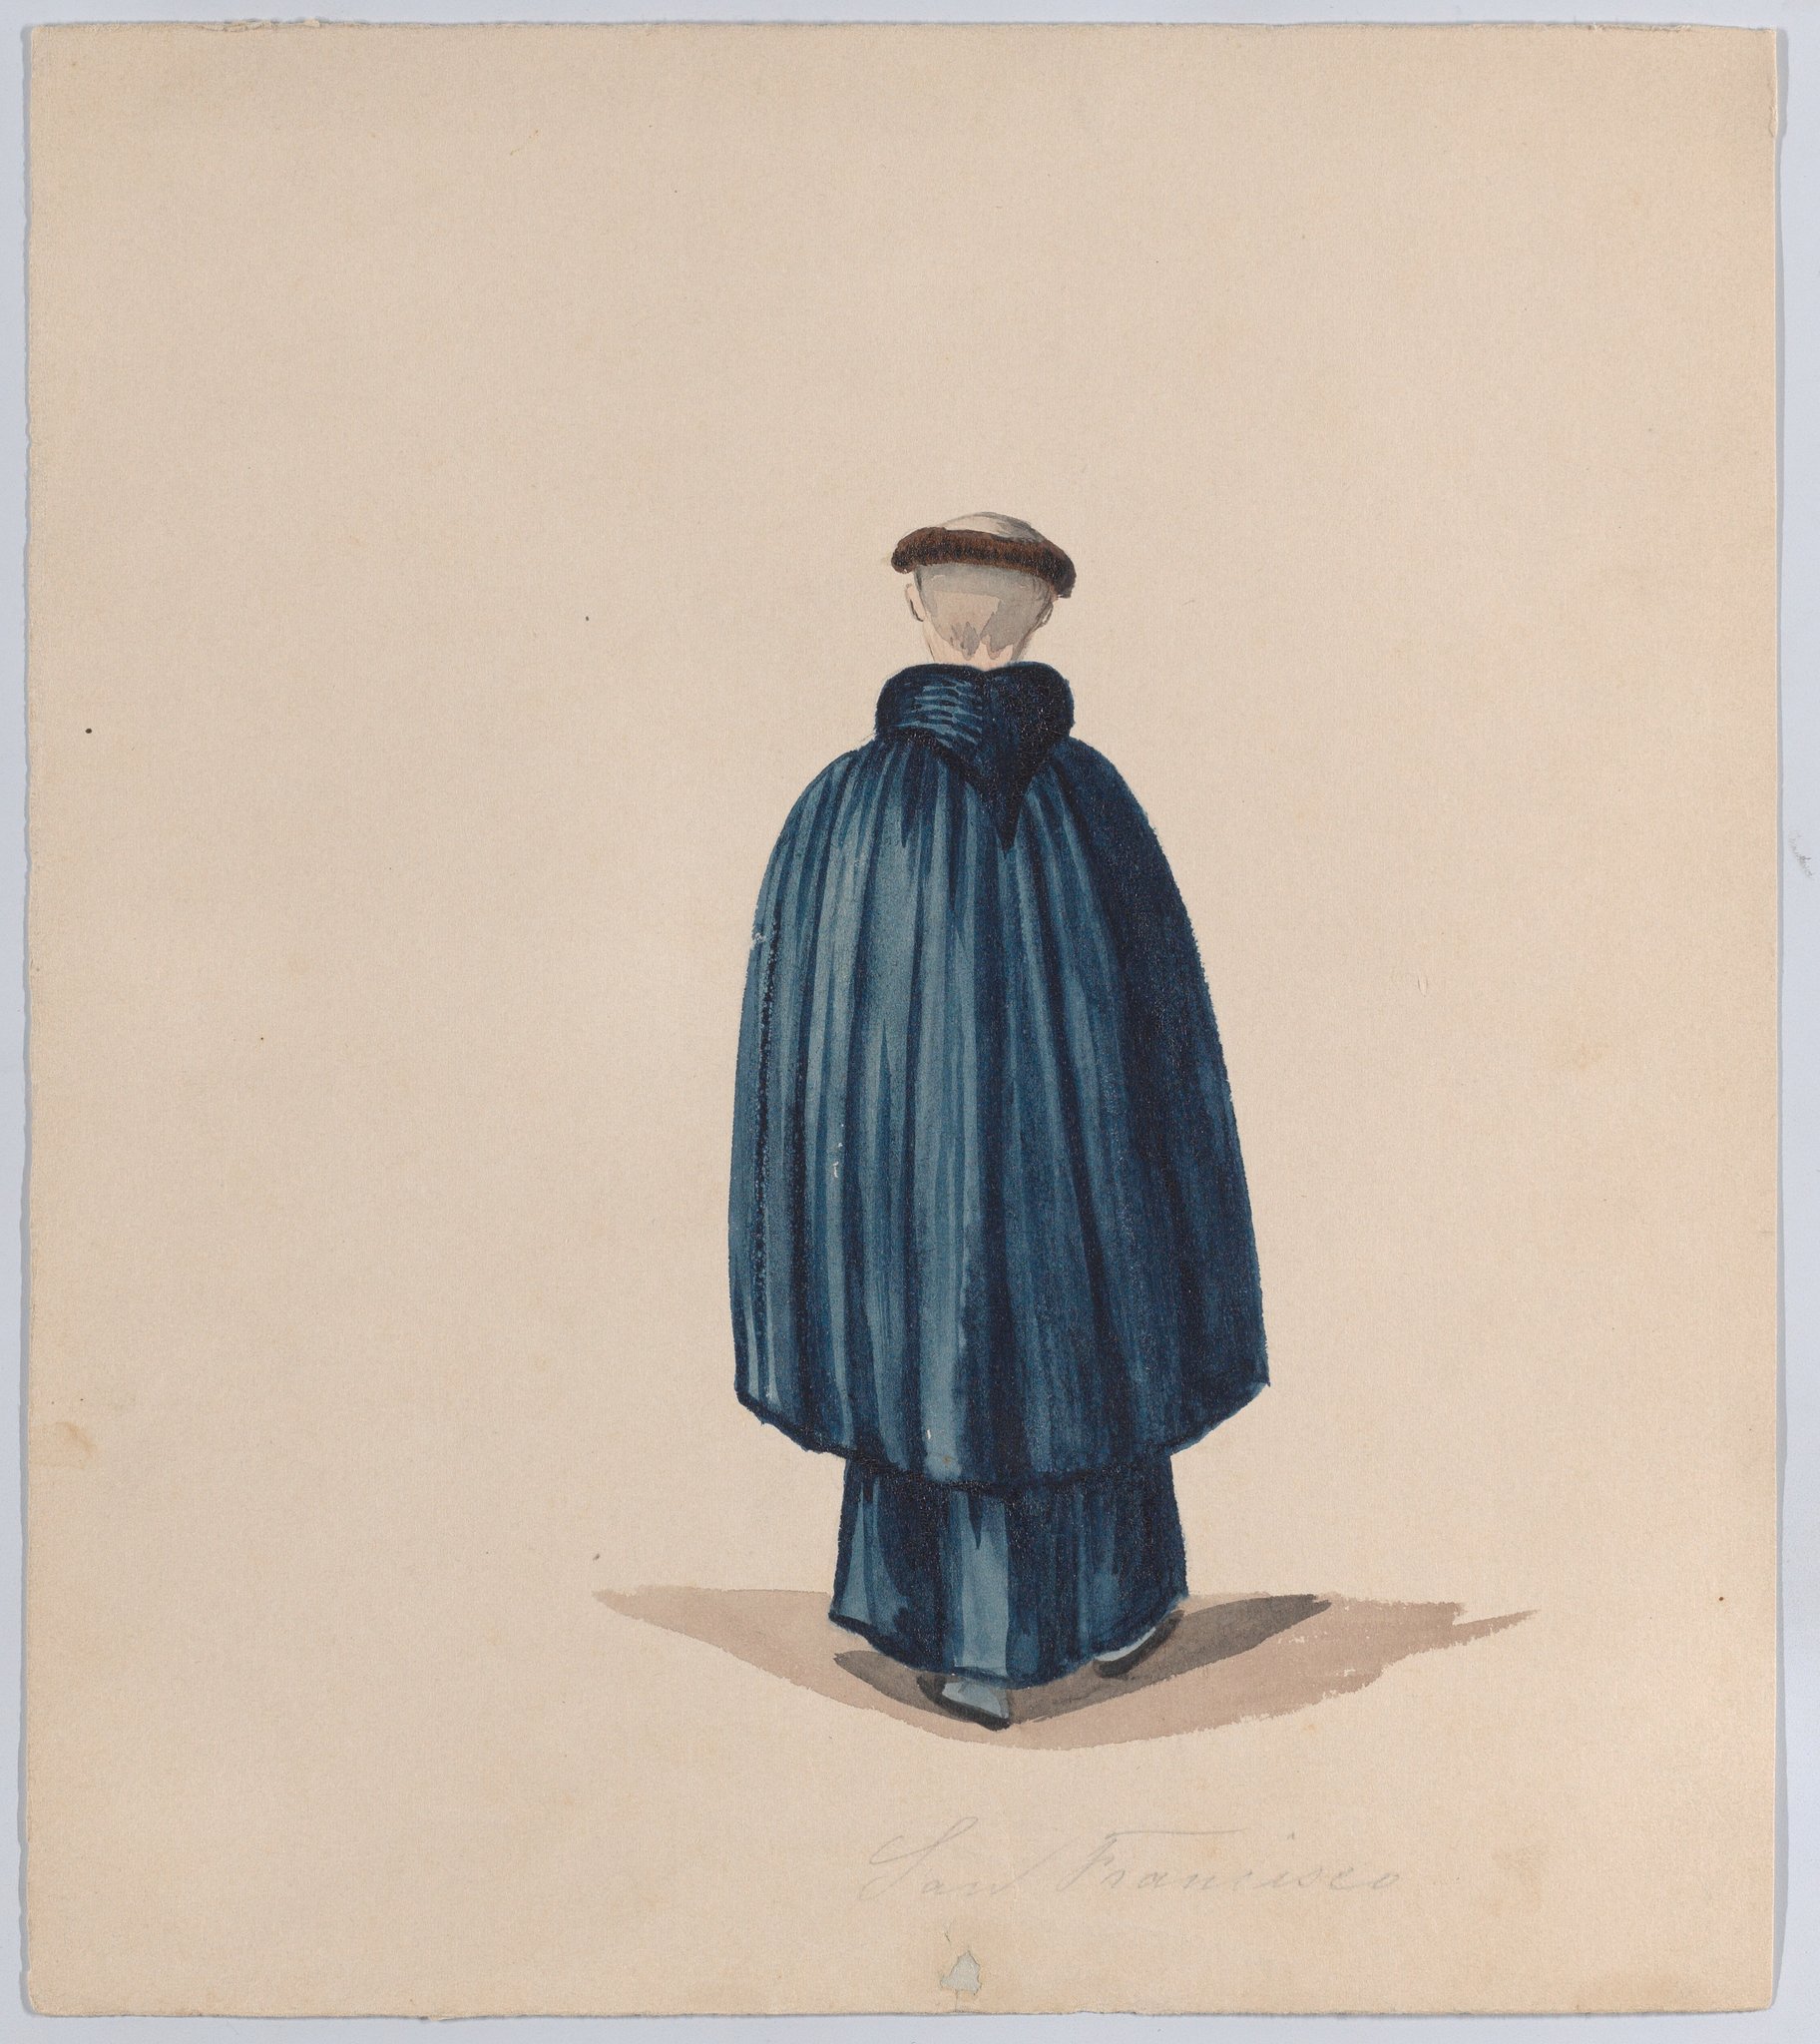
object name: drawing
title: A monk from the order of St Francis viewed from behind, from a group of drawings depicting Peruvian dress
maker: francisco (pancho) fierro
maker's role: artist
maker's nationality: african peruvian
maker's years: 1807-1879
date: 1848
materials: watercolor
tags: men,women